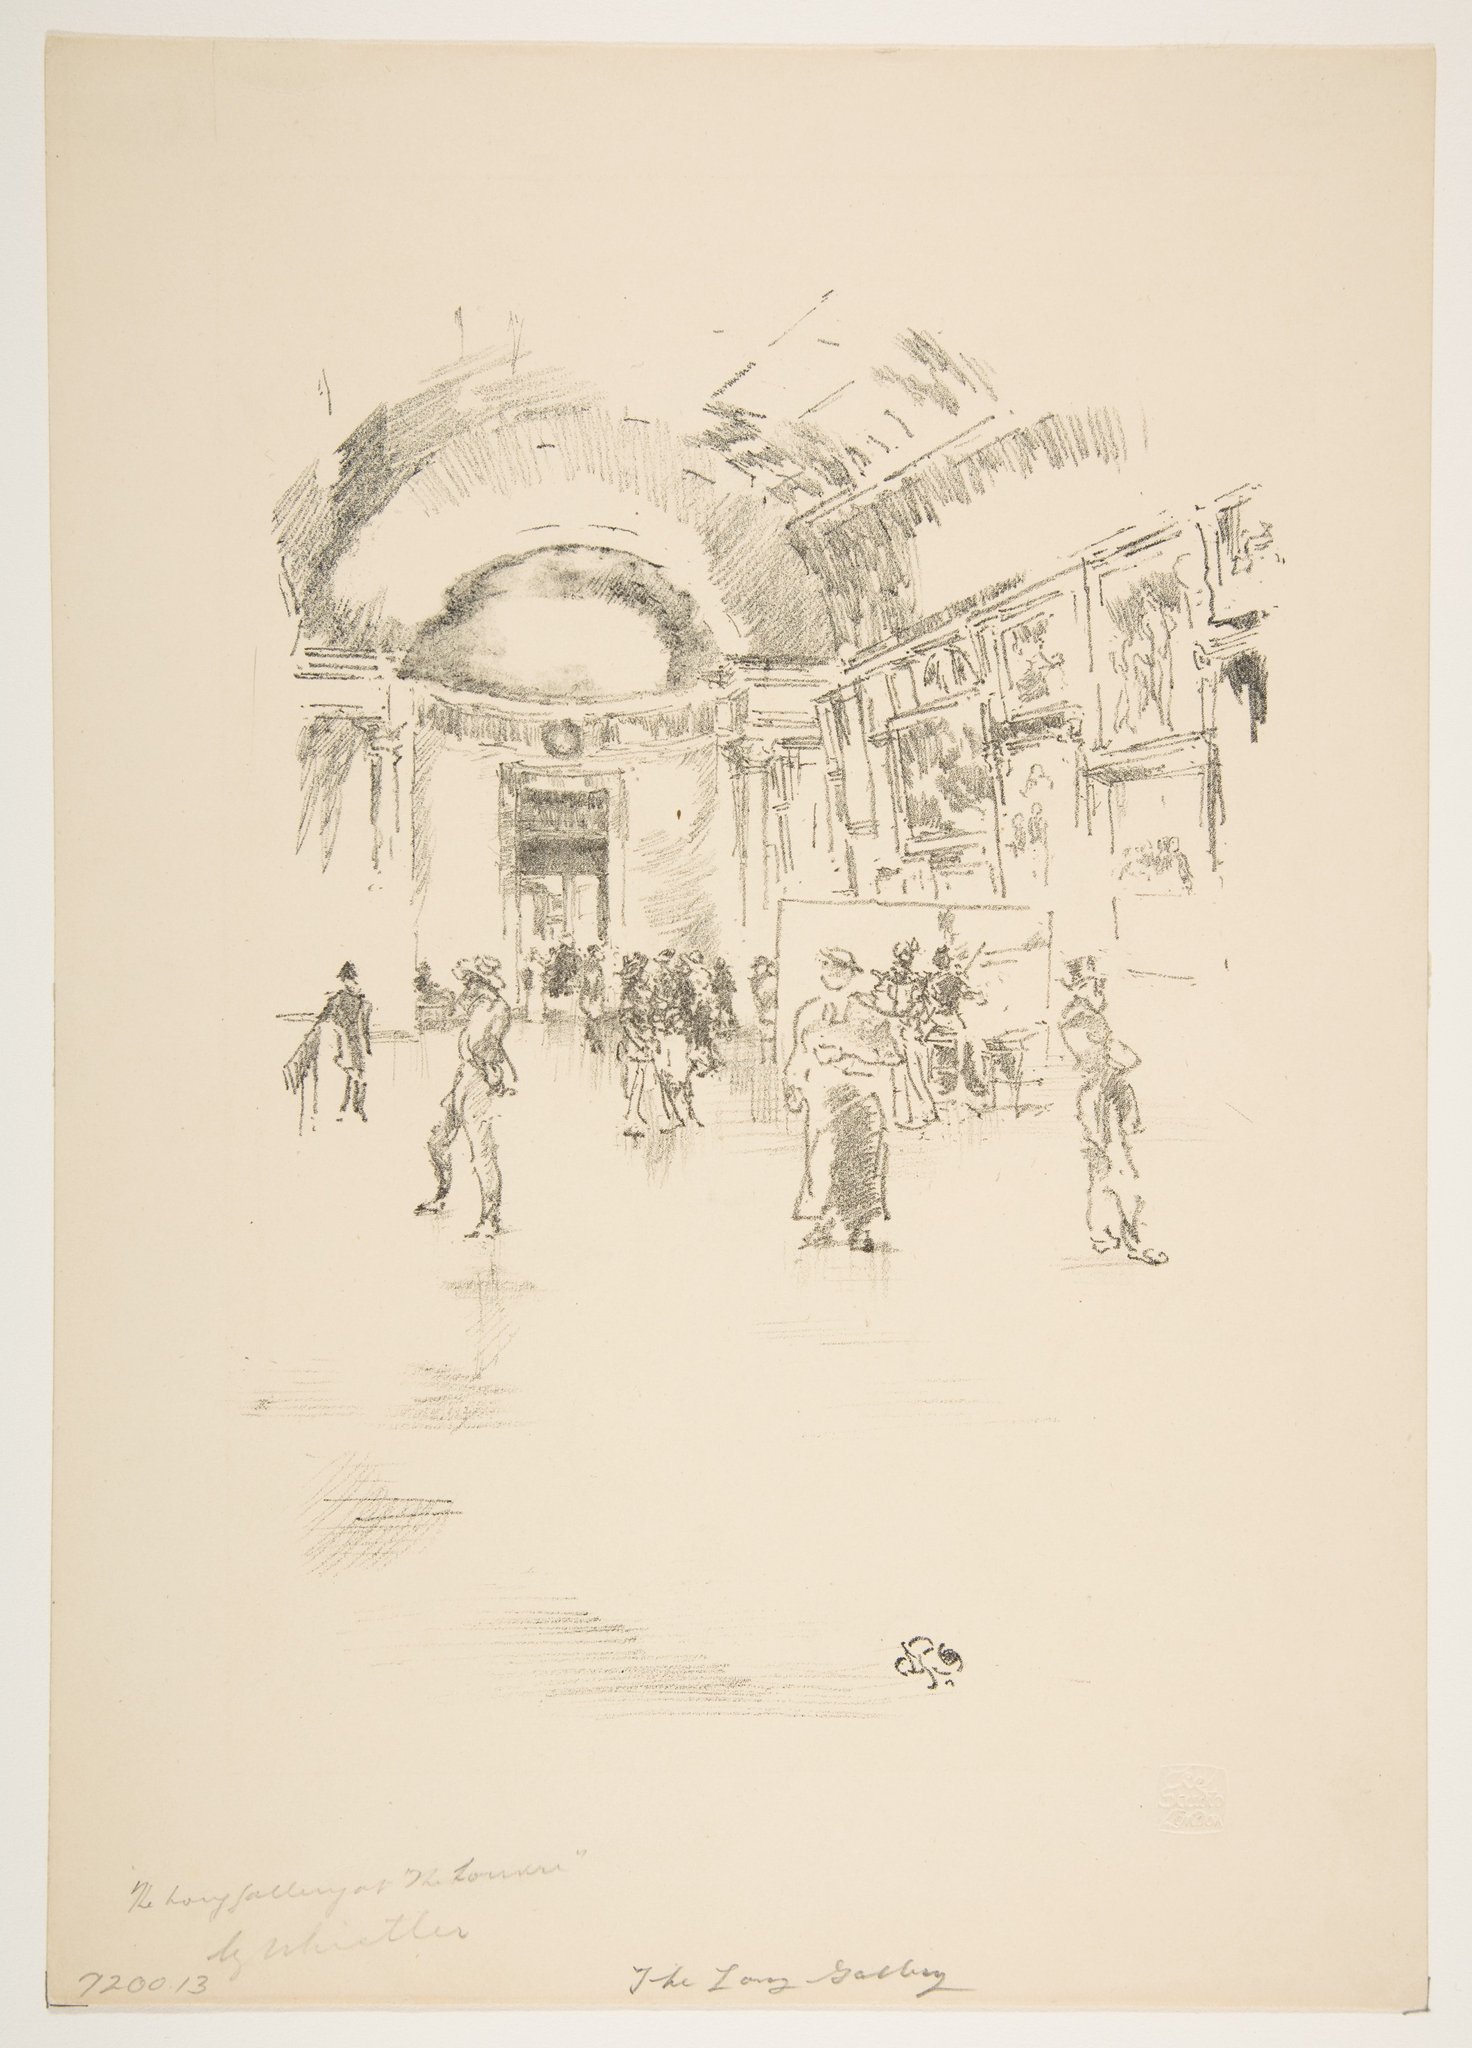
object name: print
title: The Long Gallery, Louvre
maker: james mcneill whistler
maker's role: artist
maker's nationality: american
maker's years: 1834-1903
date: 1894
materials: ink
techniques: printing, stumping, lithography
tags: museums,interiors